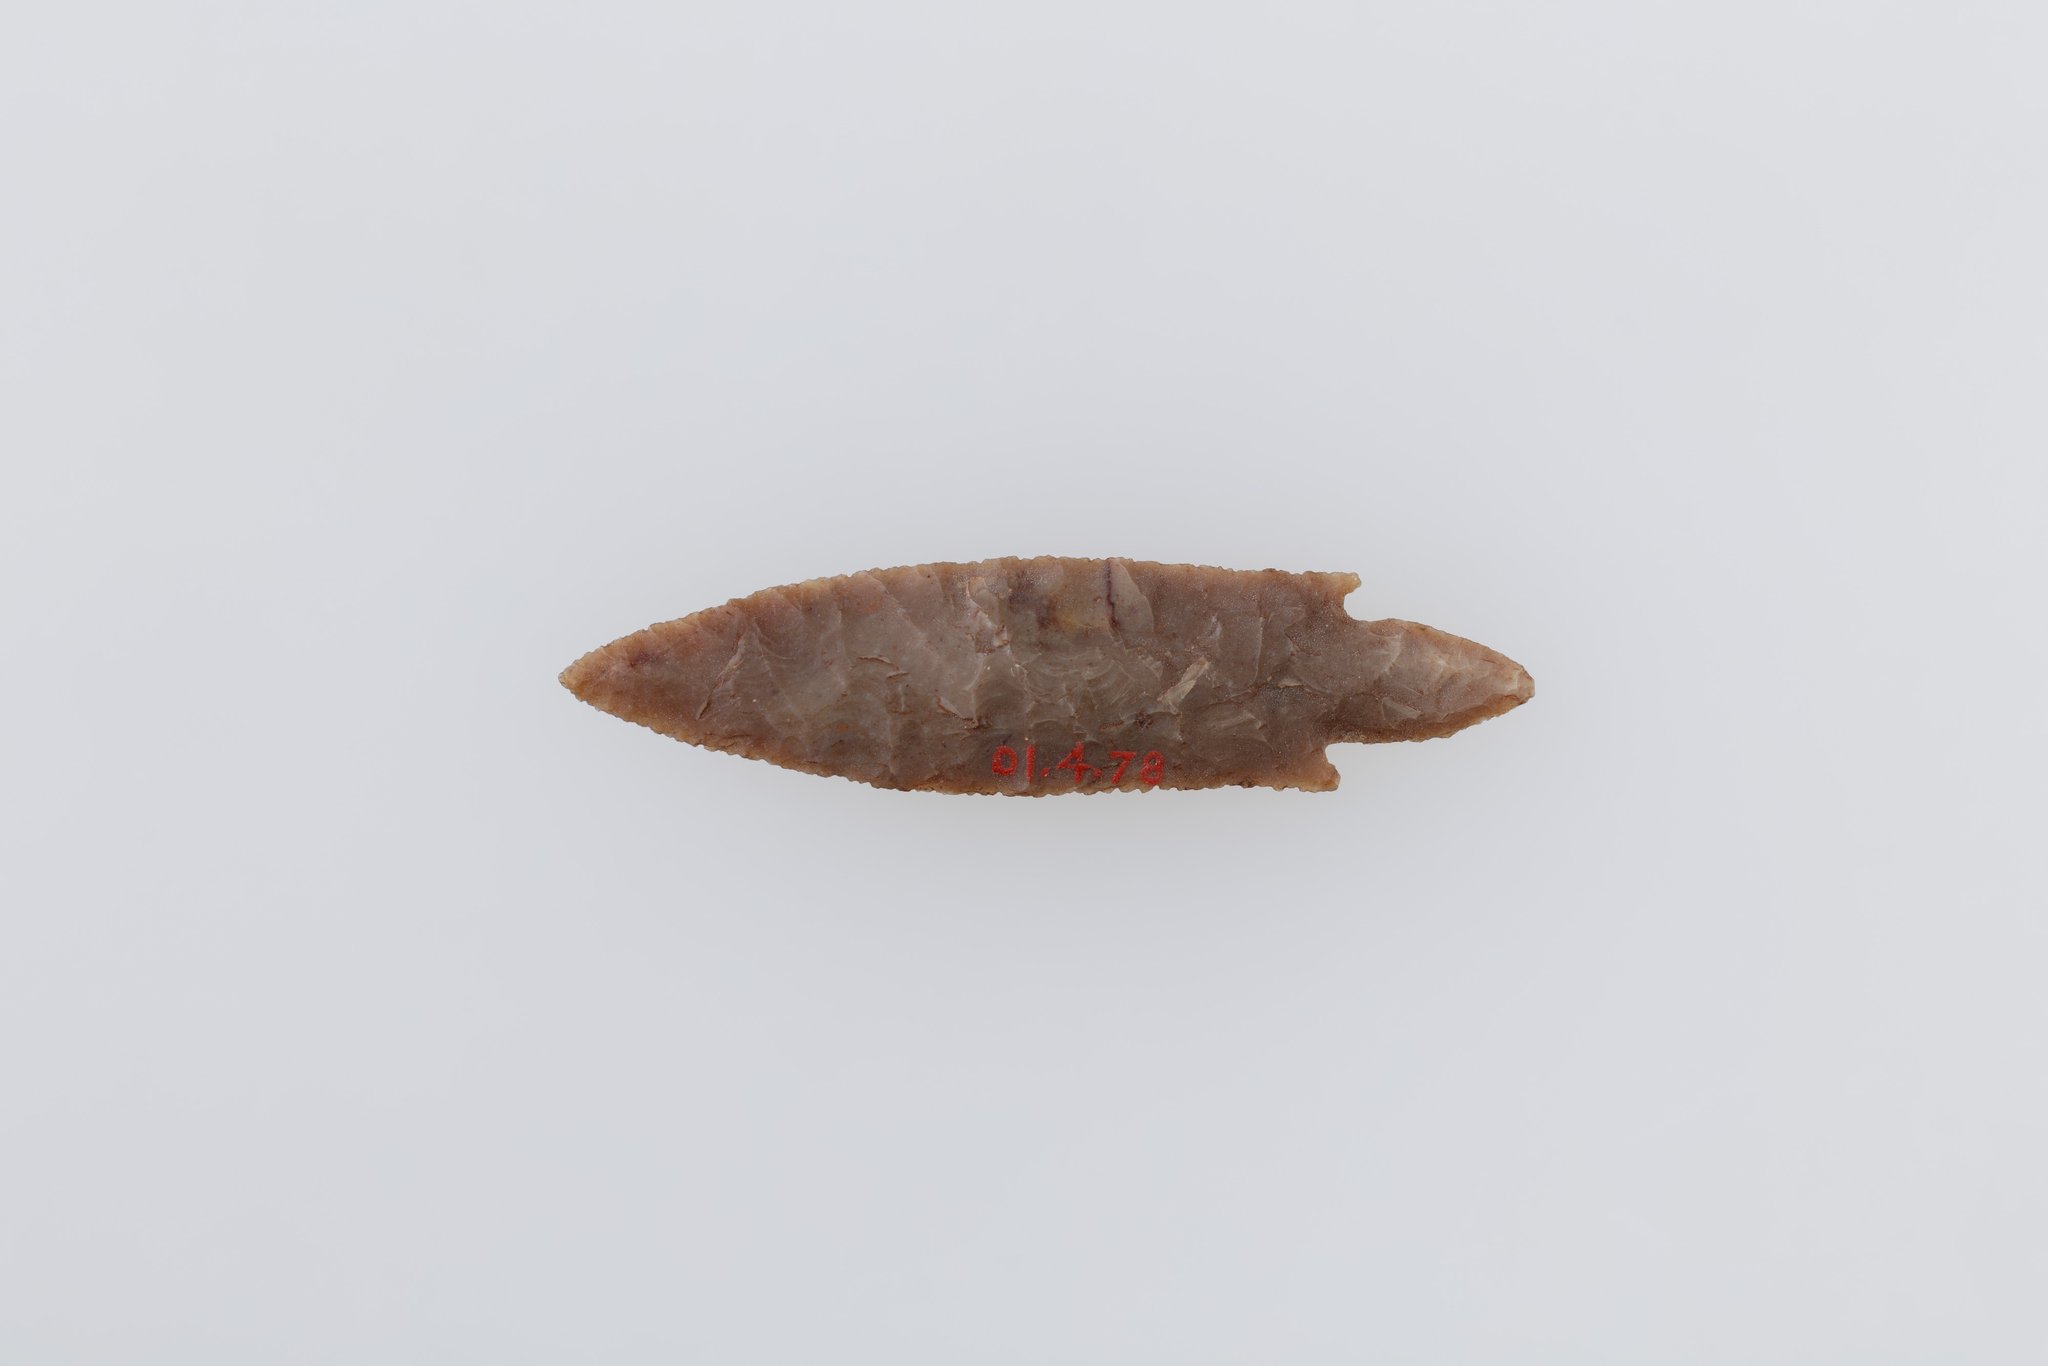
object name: arrowhead, projectile point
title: Projectile Point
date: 3100-2649 BCE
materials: stone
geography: egypt